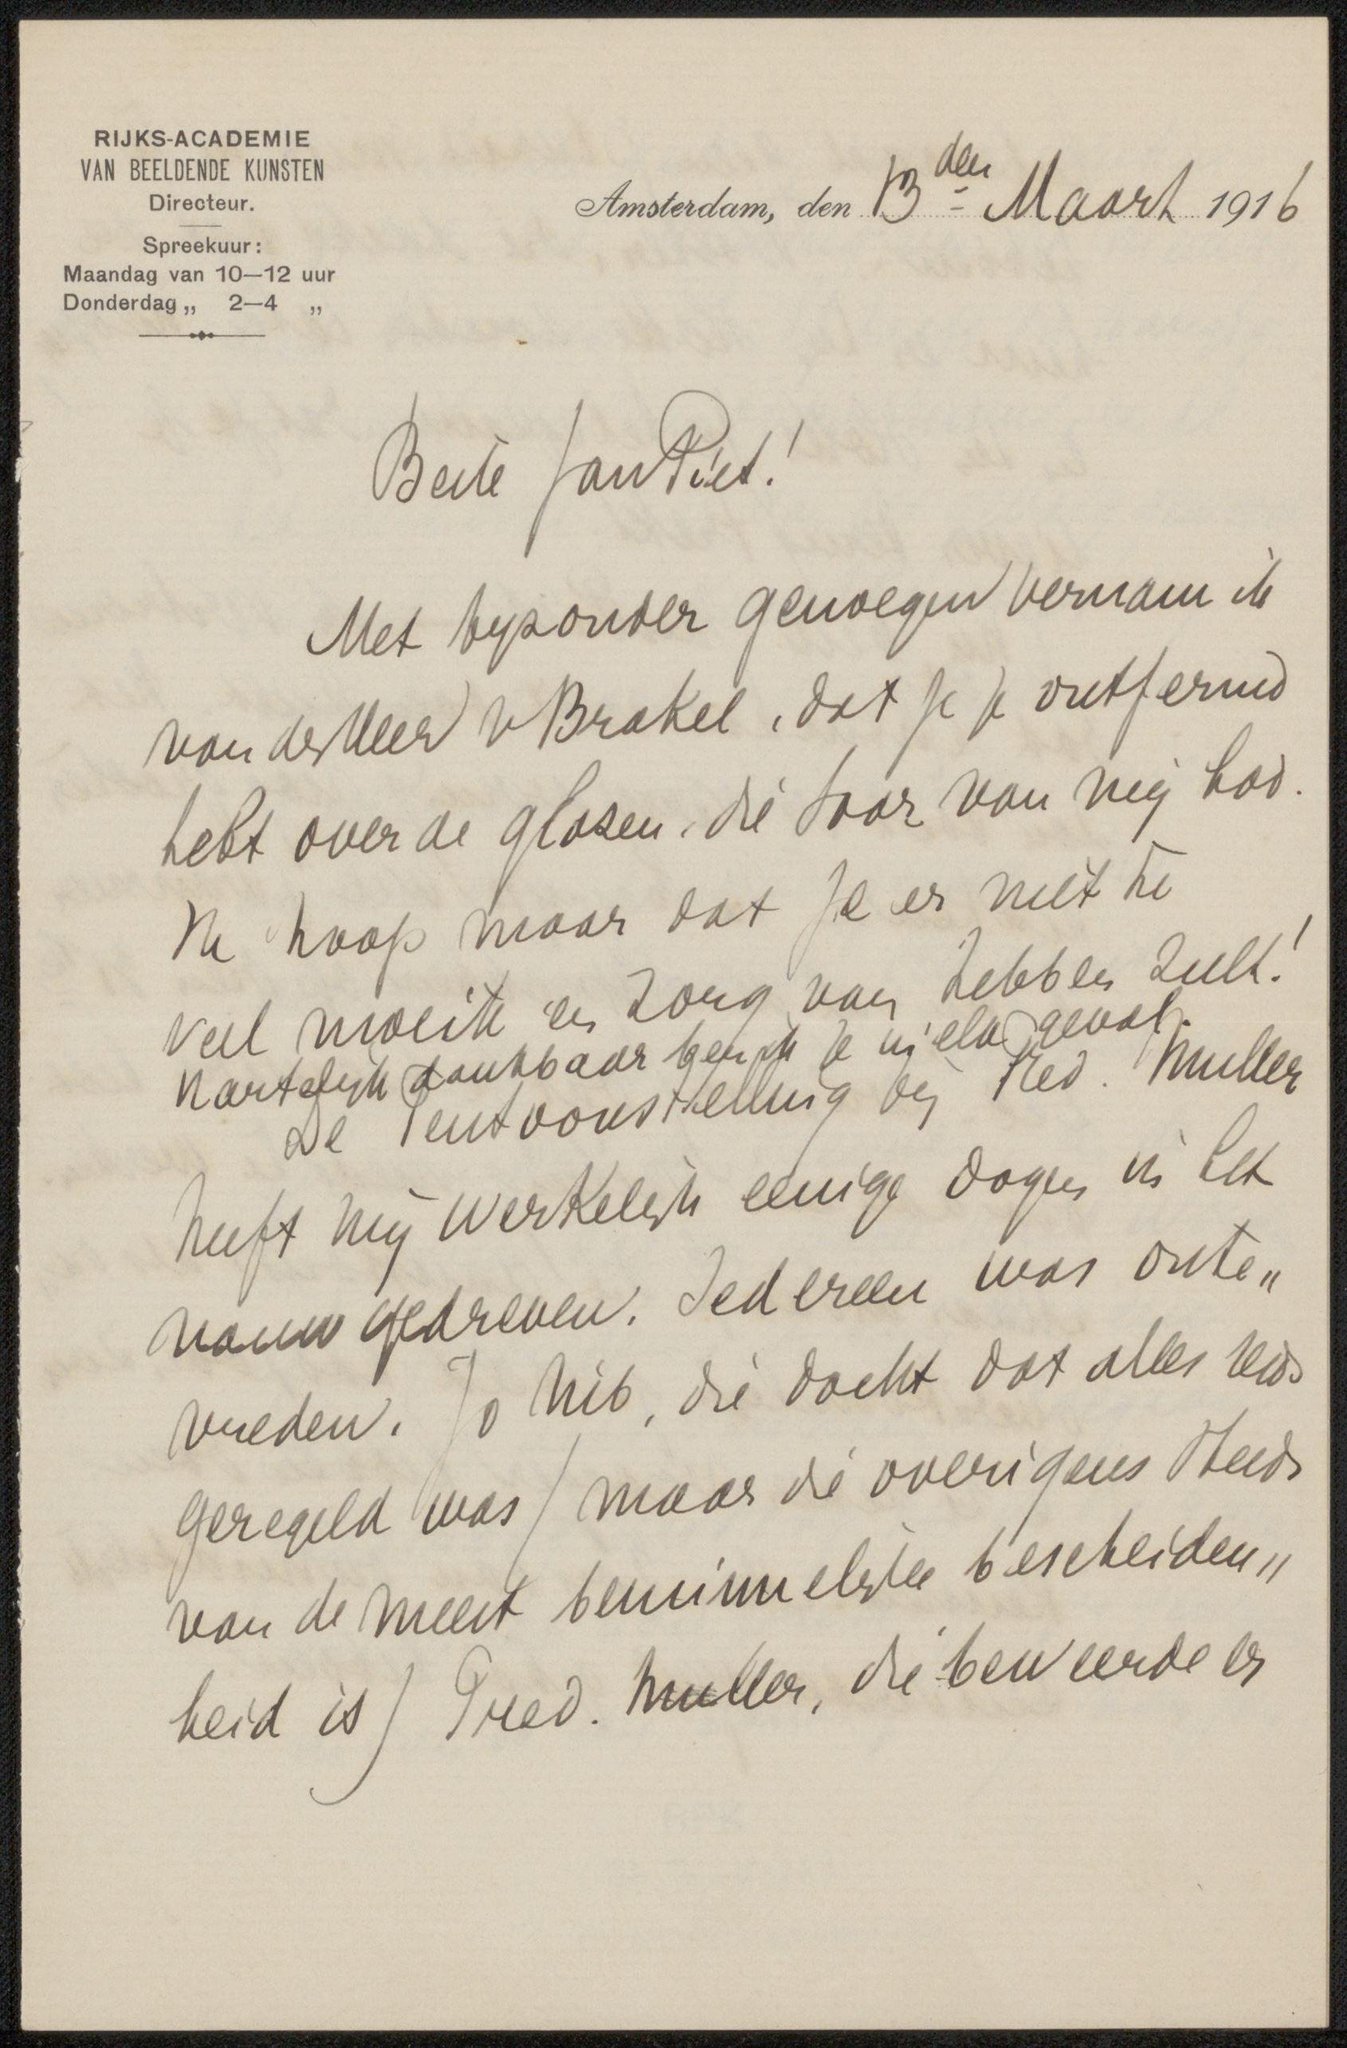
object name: letter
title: Brief aan Jan Veth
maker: antoon derkinderen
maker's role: draughtsman, painter, print maker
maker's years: 1859-1925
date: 1916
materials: ink, paper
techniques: pen, printing, writing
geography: amsterdam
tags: dordrecht, painter, print maker, draughtsman, designer, jan veth, amsterdam, antonius wilhelmus mari mensing, arnhem, anacapri, saar de swart, applied arts, arts and crafts; industrial design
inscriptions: collector's mark: ‘RPK’